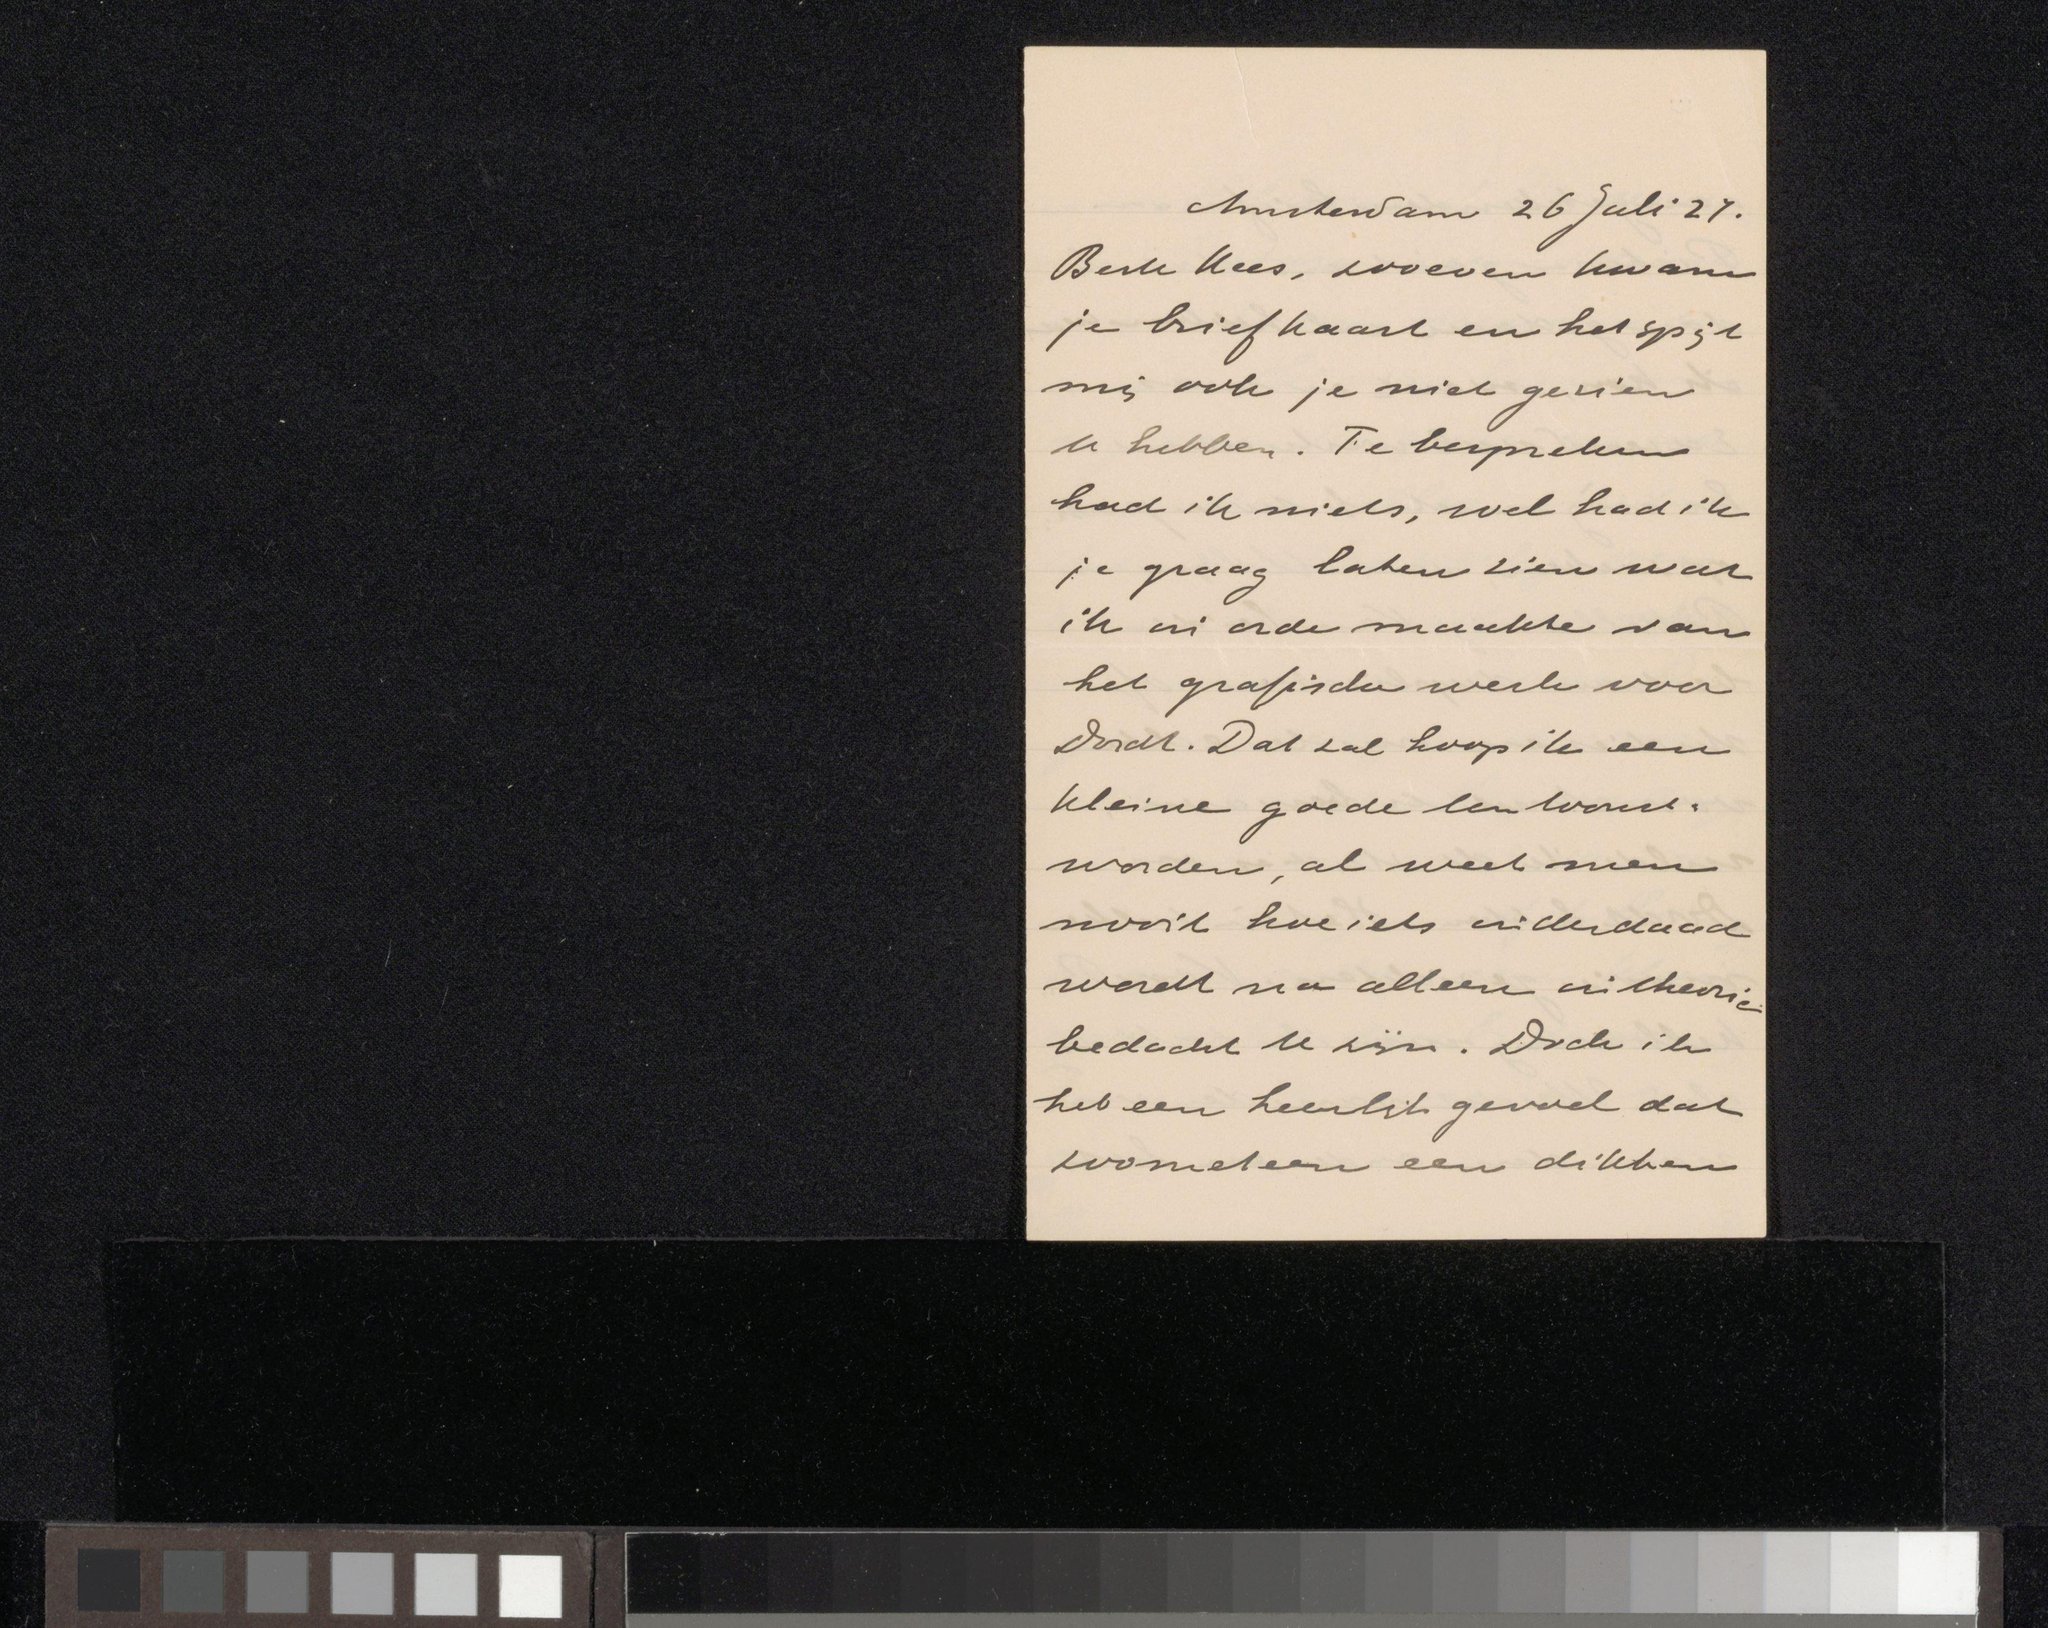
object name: letter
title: Brief aan Cornelis Gerardus 't Hooft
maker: anna dorothea dirks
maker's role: artist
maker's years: 1863-1929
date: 1927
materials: ink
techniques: pen, writing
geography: amsterdam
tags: schools, amsterdam, painter, cornelis gerardus 't hooft, the graphic arts, exhibition ~ art, dordrecht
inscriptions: collector's mark: ‘RPK’